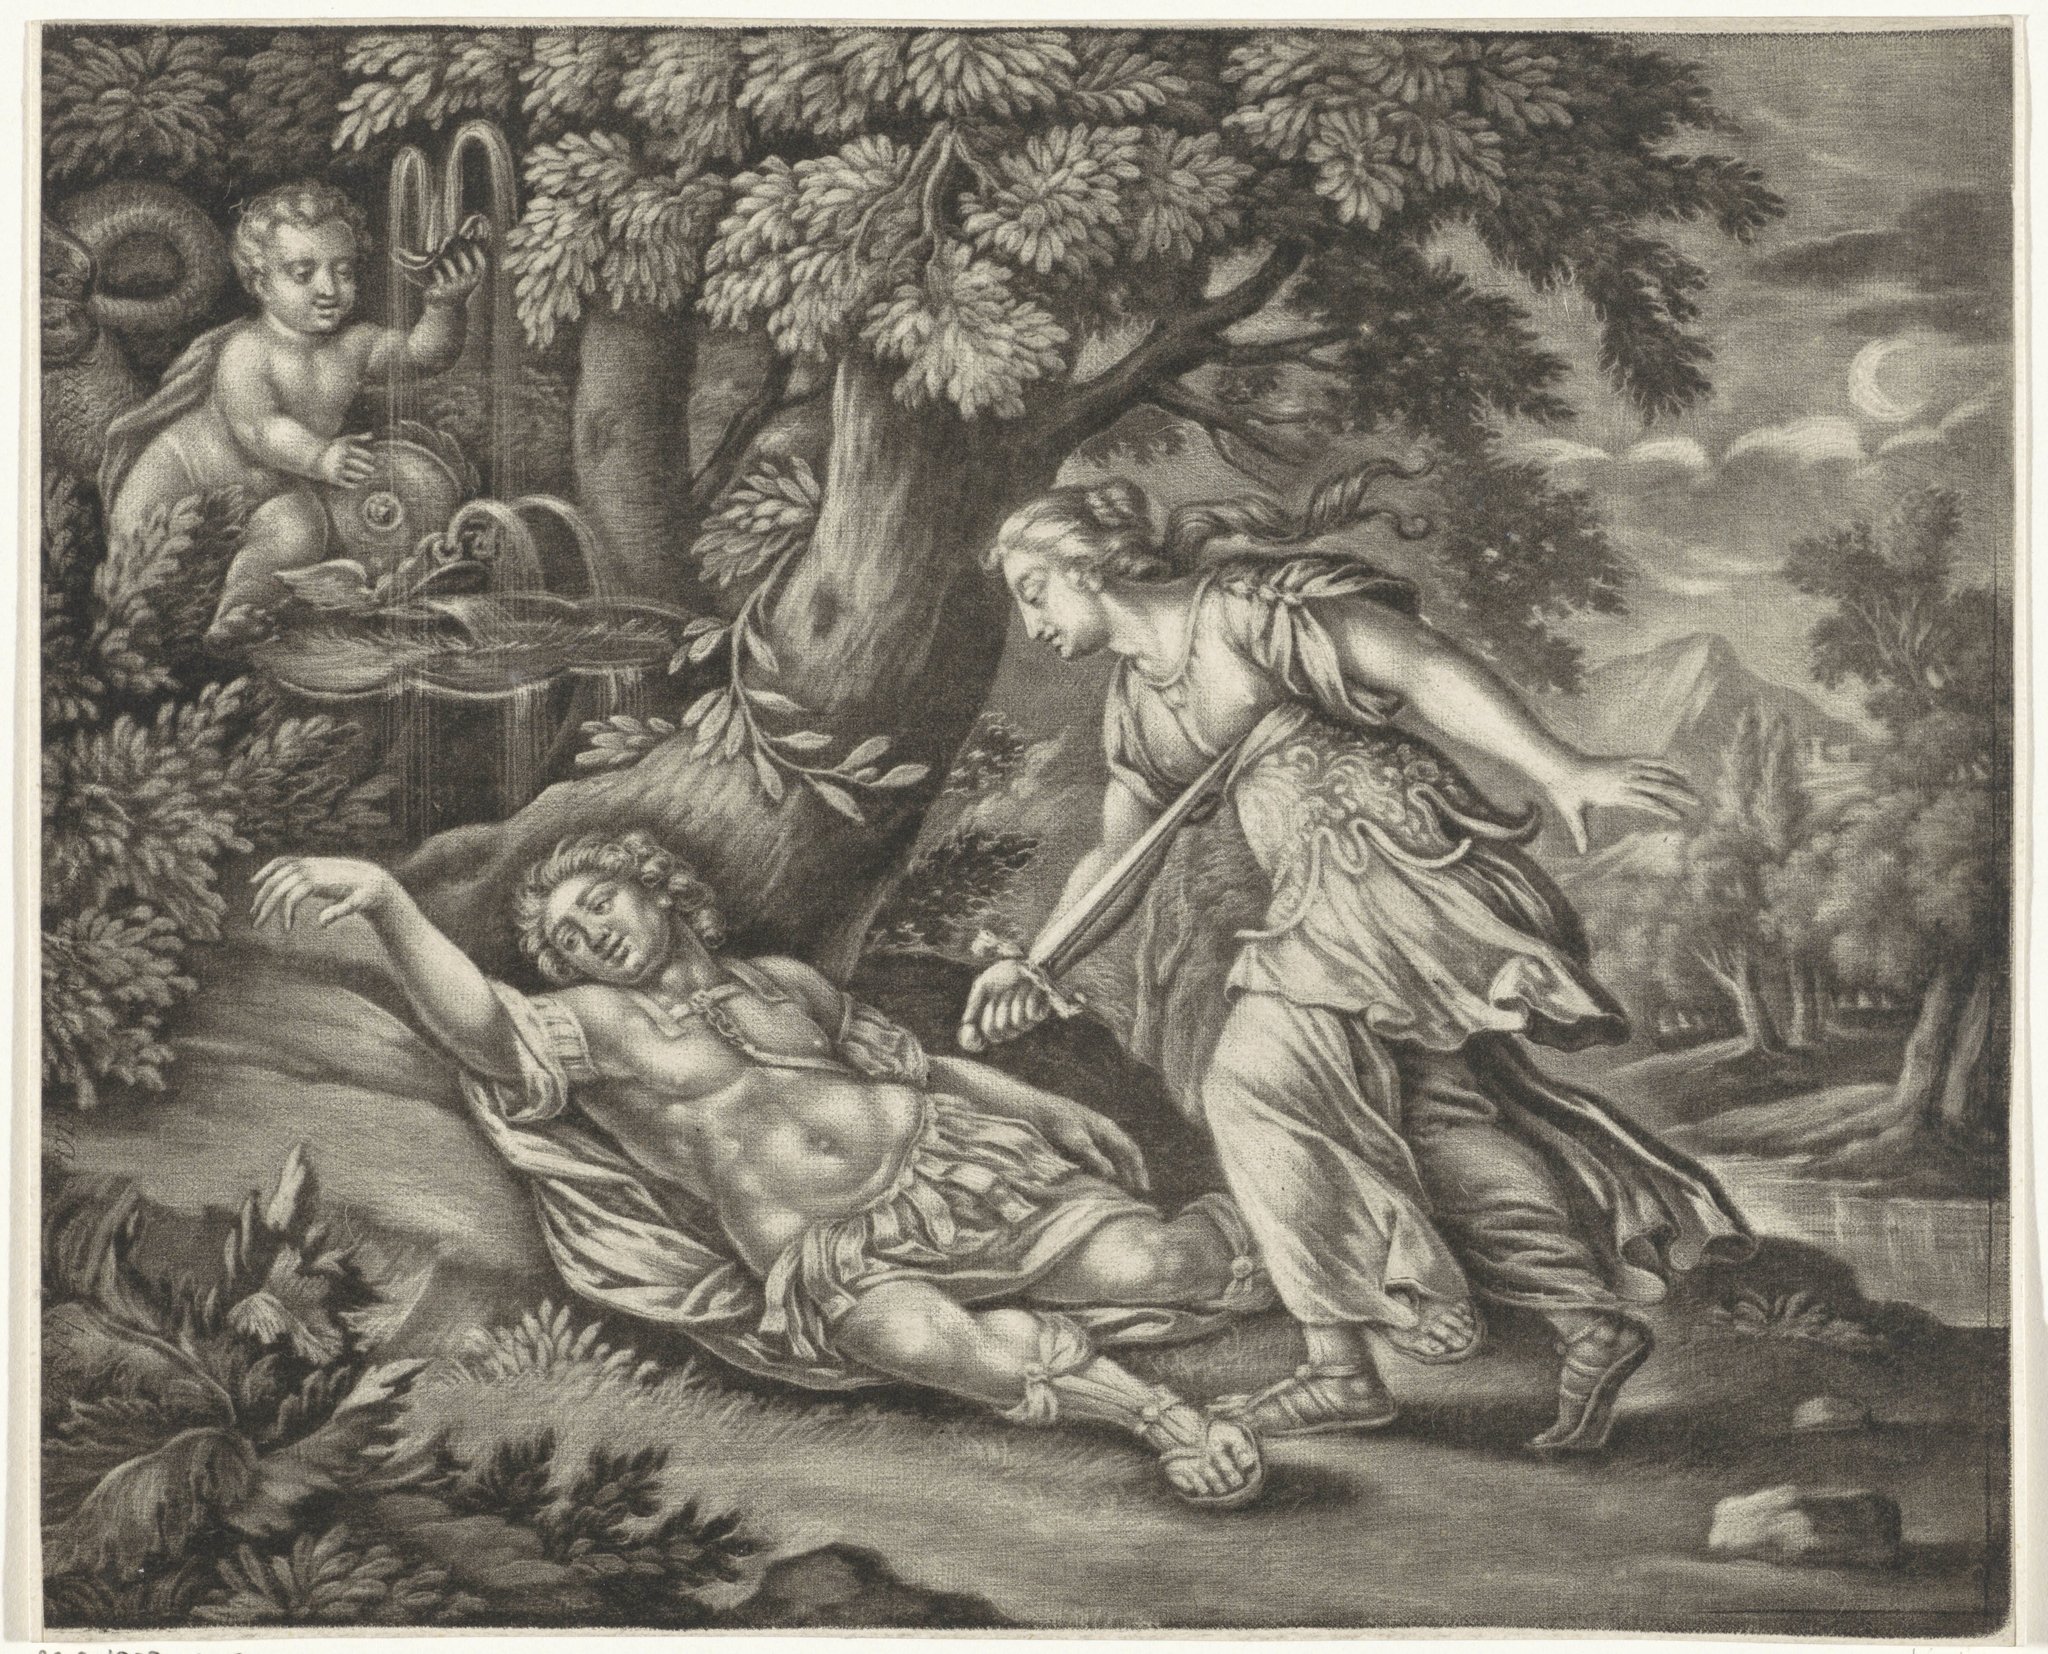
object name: print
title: Pyramus en Thisbé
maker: jan van somer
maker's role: draughtsman, print maker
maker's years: 1645-1699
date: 1655-1700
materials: paper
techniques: mezzotint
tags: thisbe kills herself with pyramus' sword (the scene may be represented near a fountain), thisbe discovers the dying pyramus (the scene may be represented near a fountain)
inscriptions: collector's mark: Lugt 2228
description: Pyramus stak zichzelf neer met zijn zwaard nadat hij meende dat Thisbe door een leeuw was gedood. Thisbe ontdekt haar stervende geliefde, waarop zij zichzelf ook neersteekt.